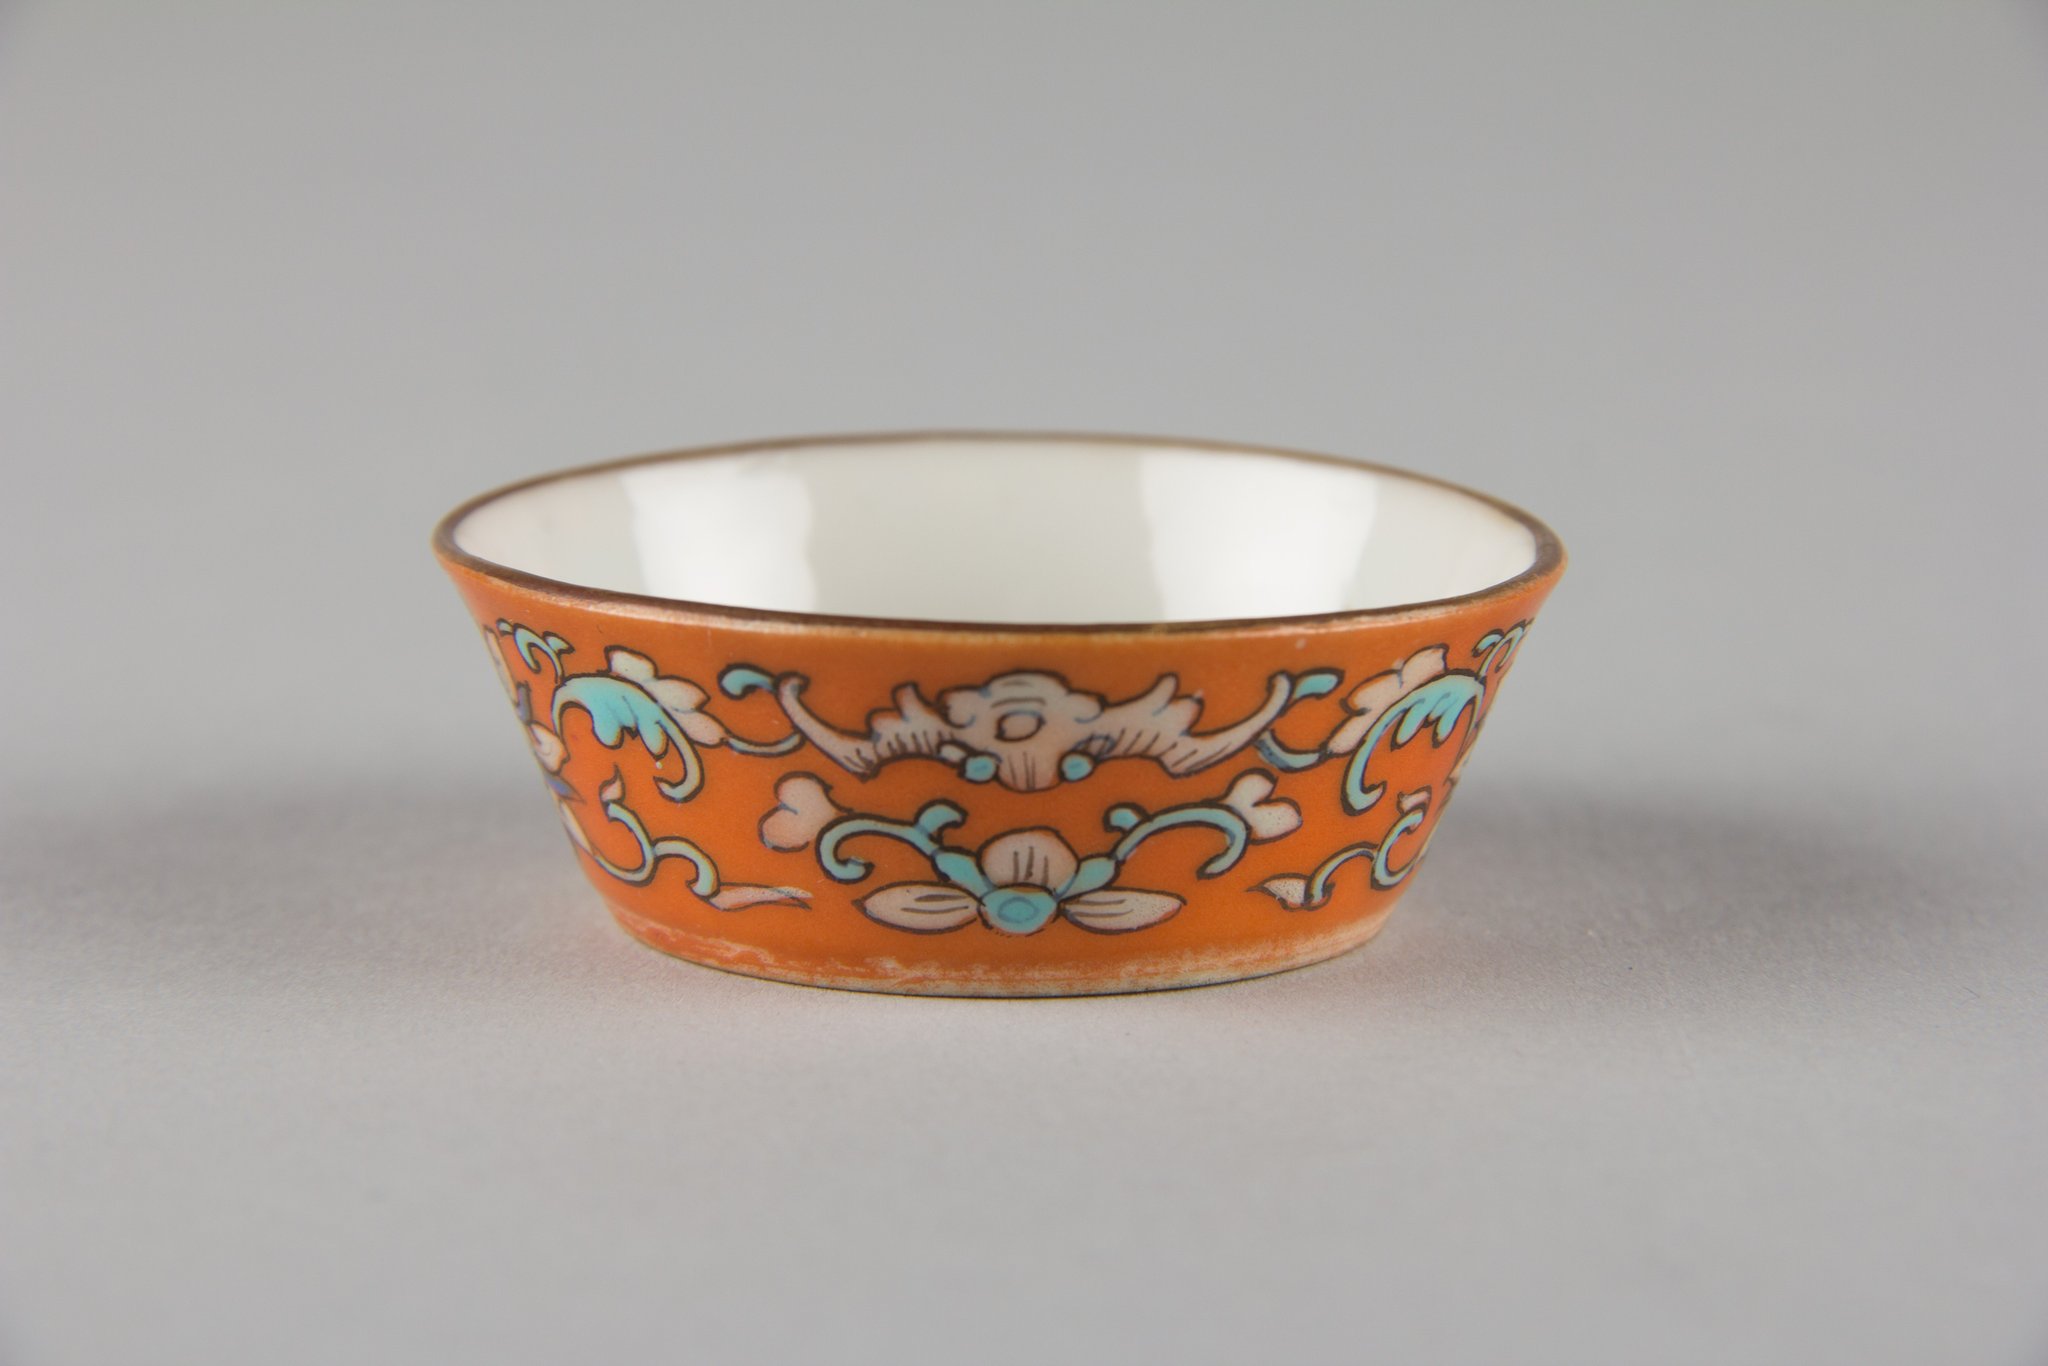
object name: cup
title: Cup (from a set of eight)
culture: chinese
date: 1644-1911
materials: enamel, glaze, iron, porcelain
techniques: overglaze, painting, polychrome